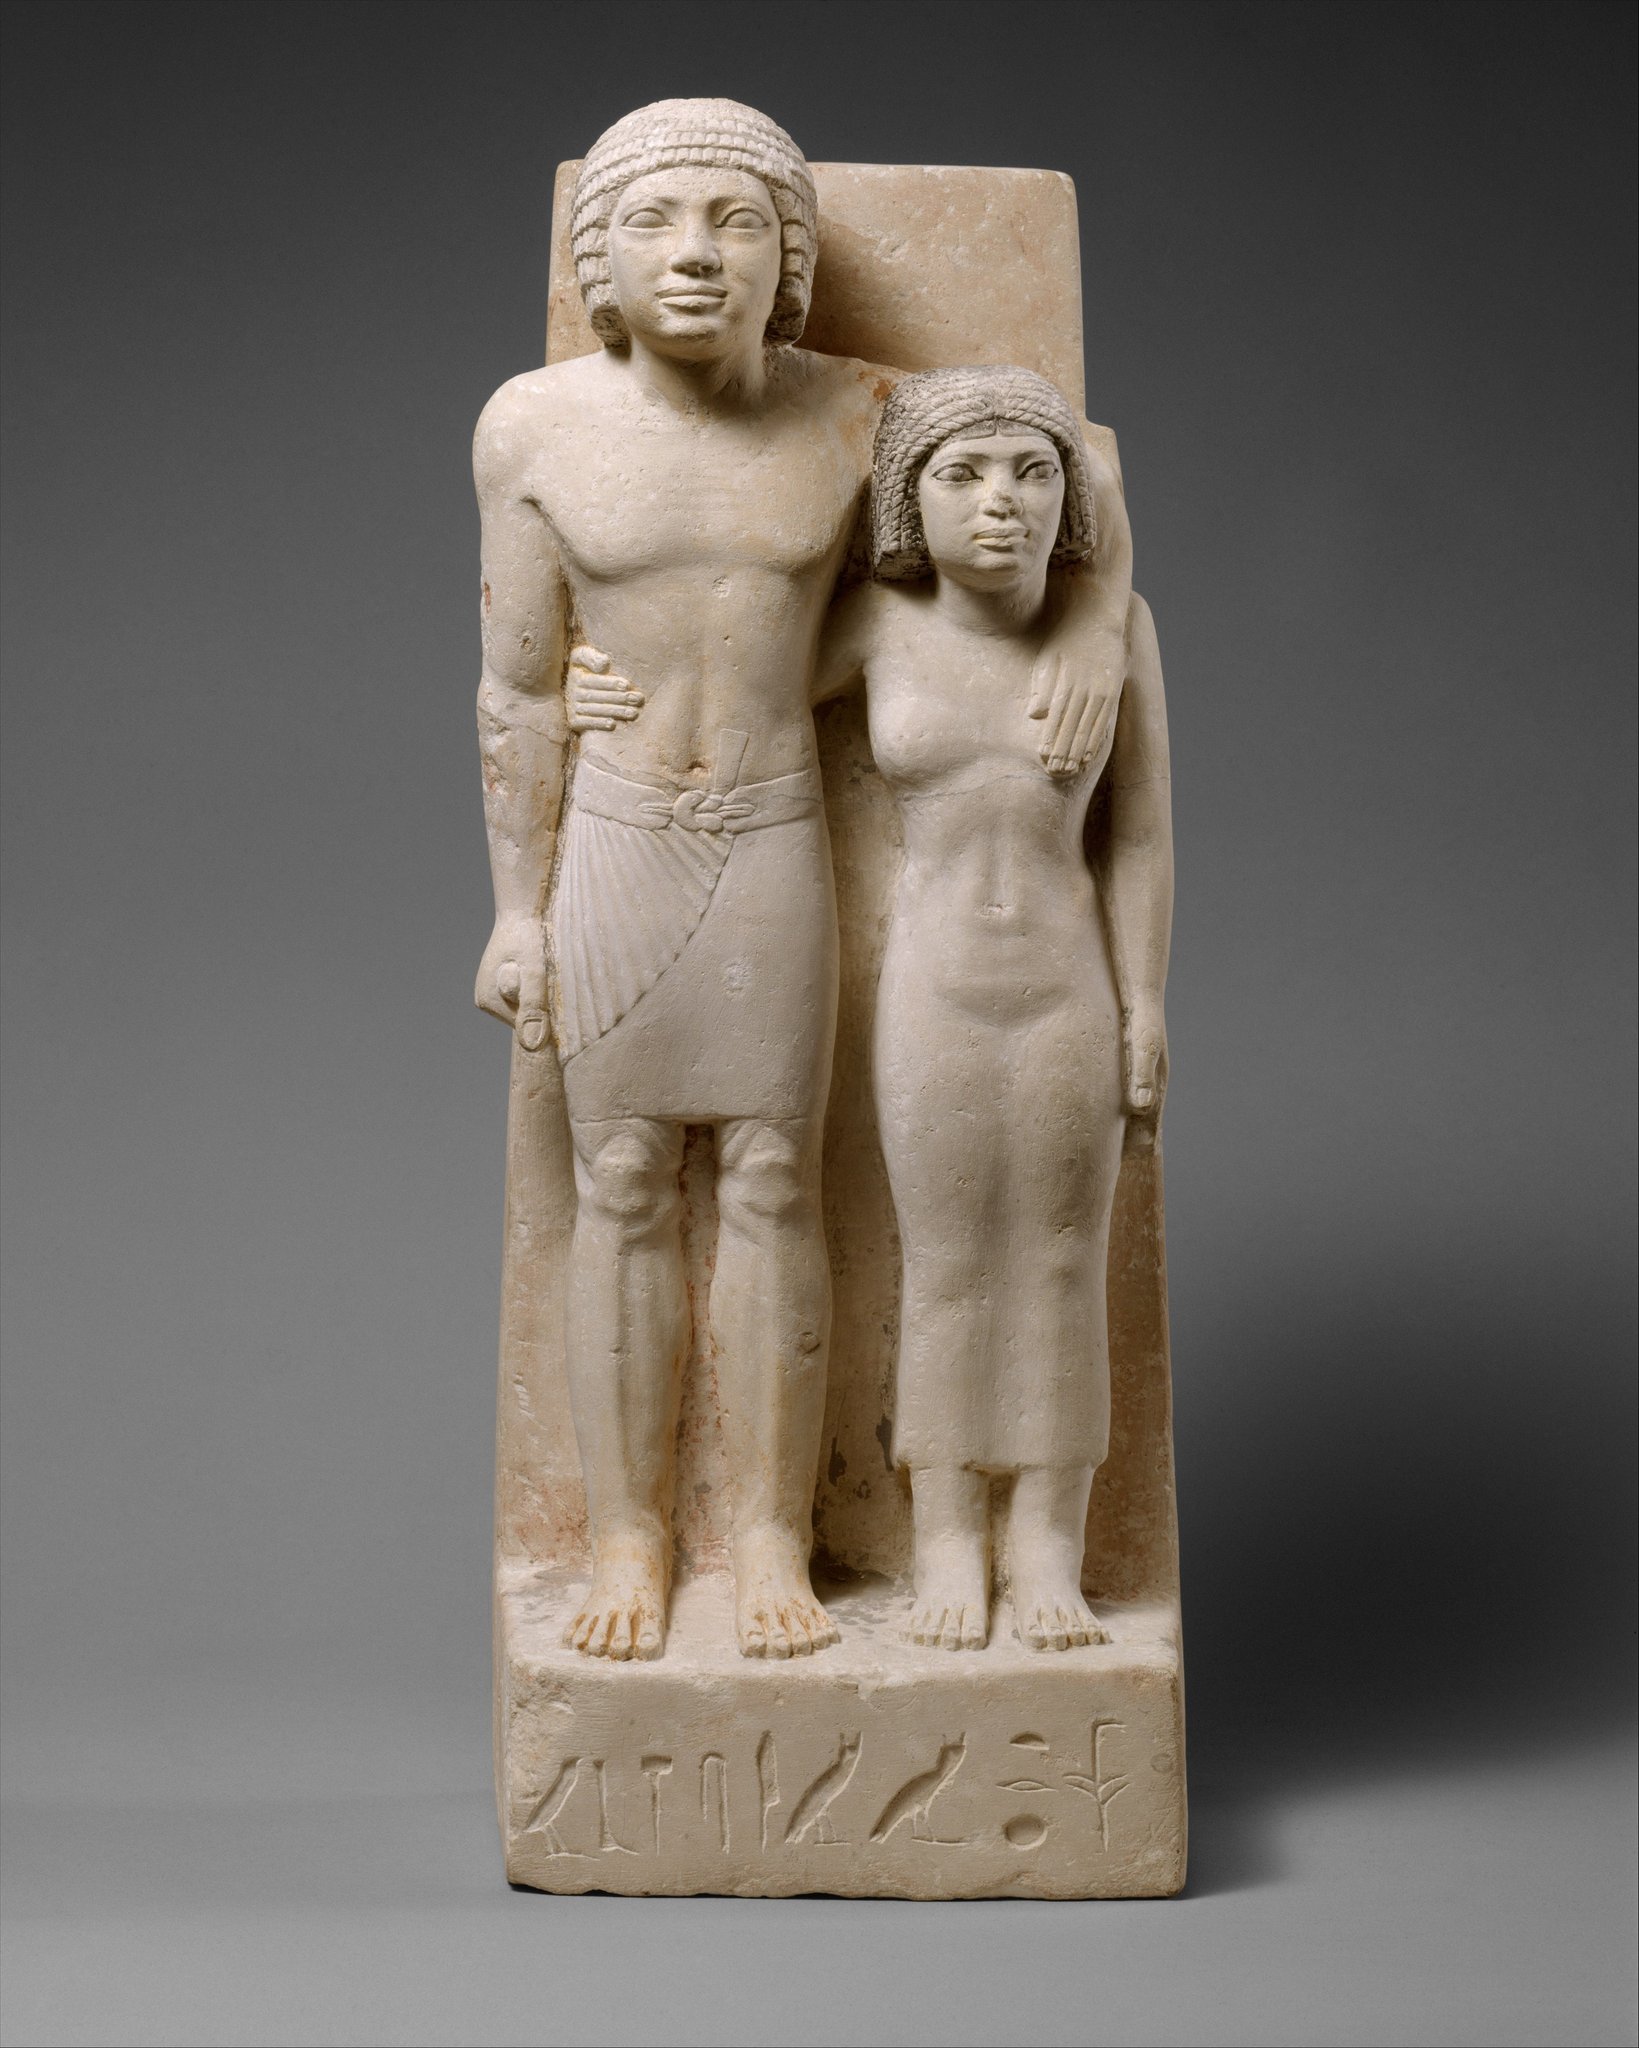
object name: statue, standing pair, memi, sabu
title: The King's Acquaintances Memi and Sabu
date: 2575-2465 BCE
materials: limestone, paint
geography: memphite region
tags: couples,men,women